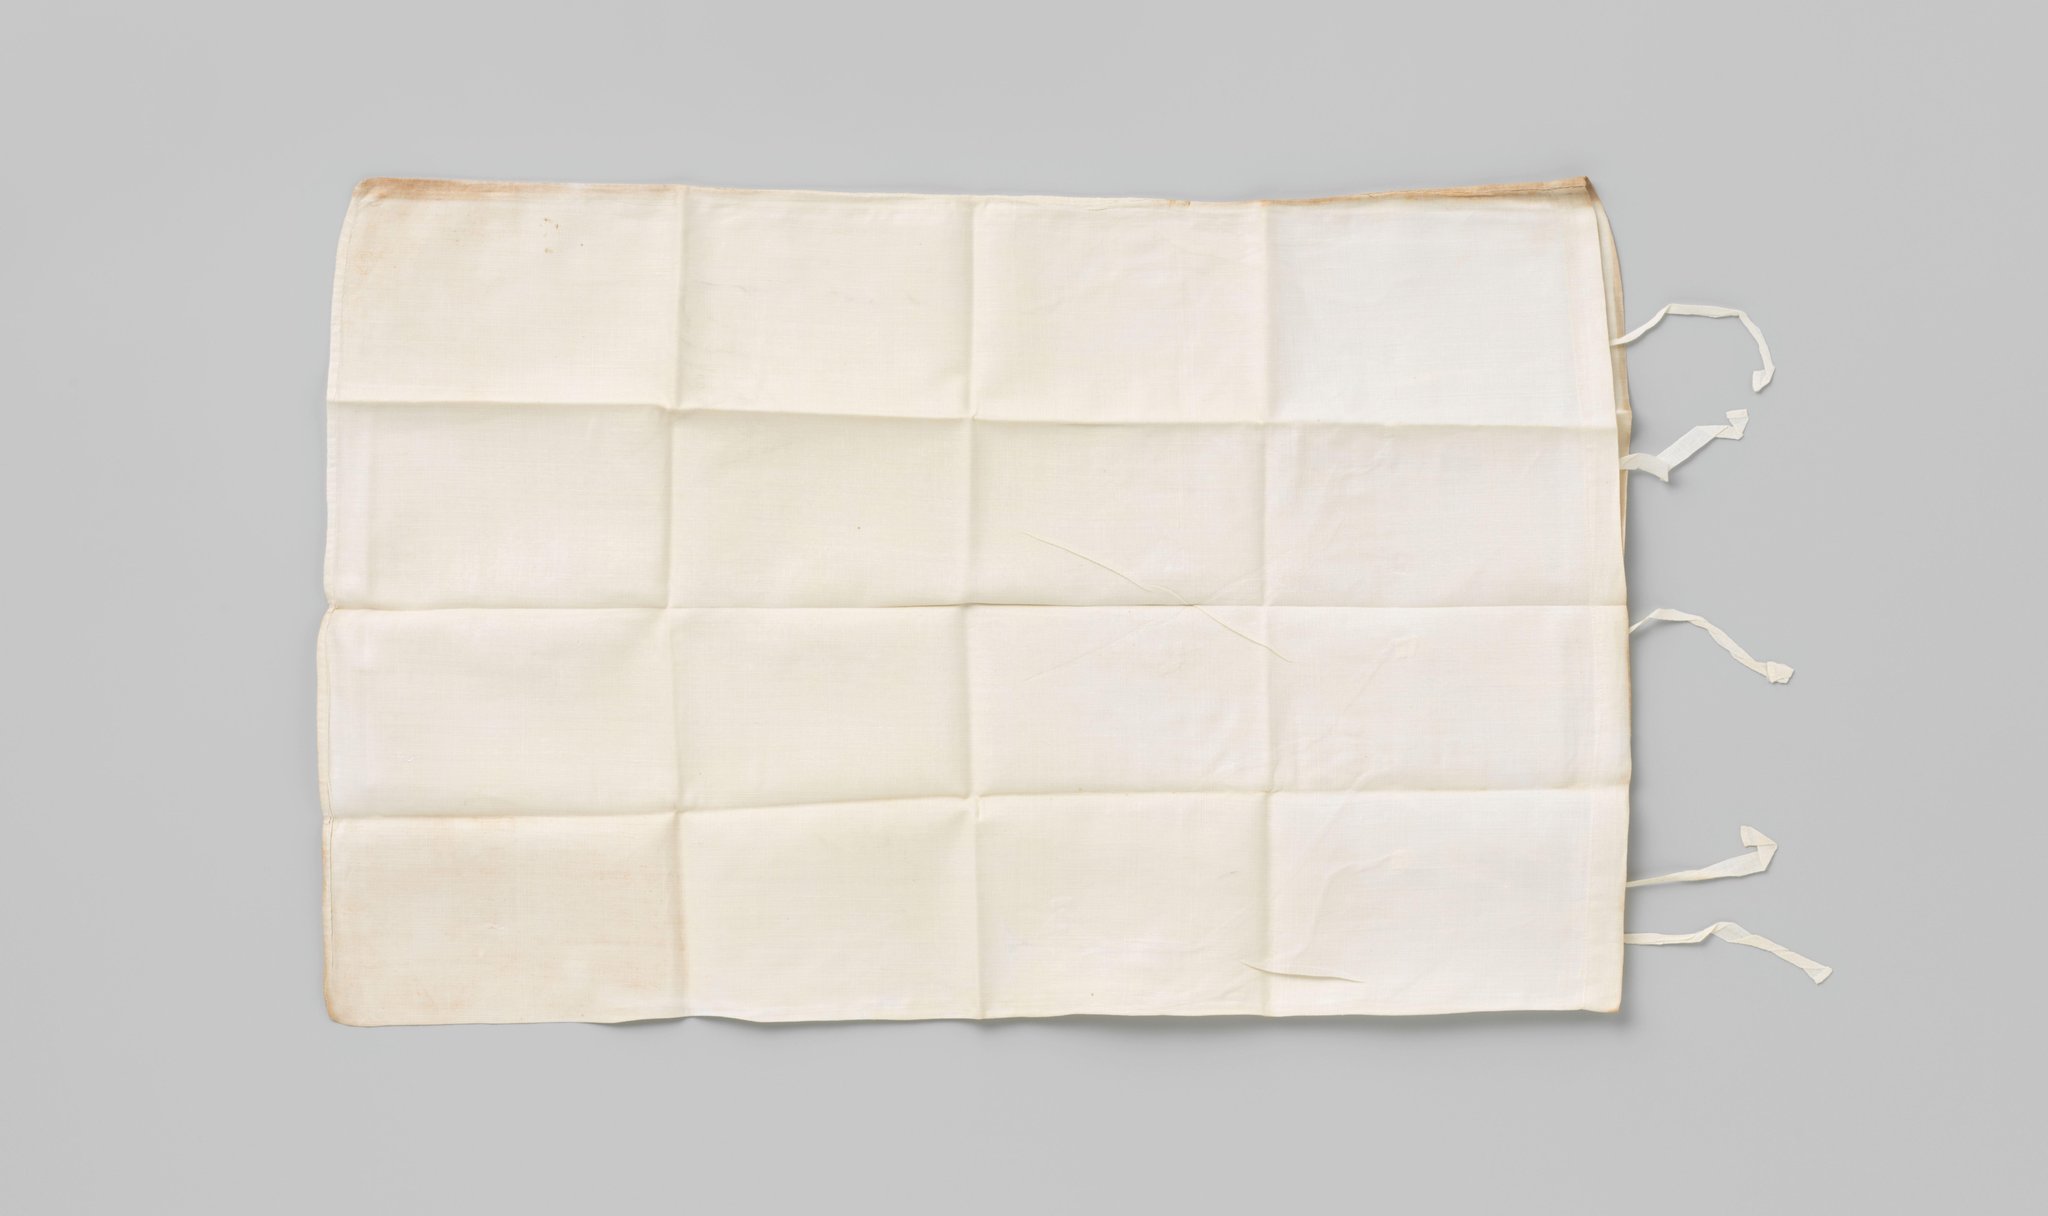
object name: lendensloop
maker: Anonymous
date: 1880-1934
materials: linen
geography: northern netherlands